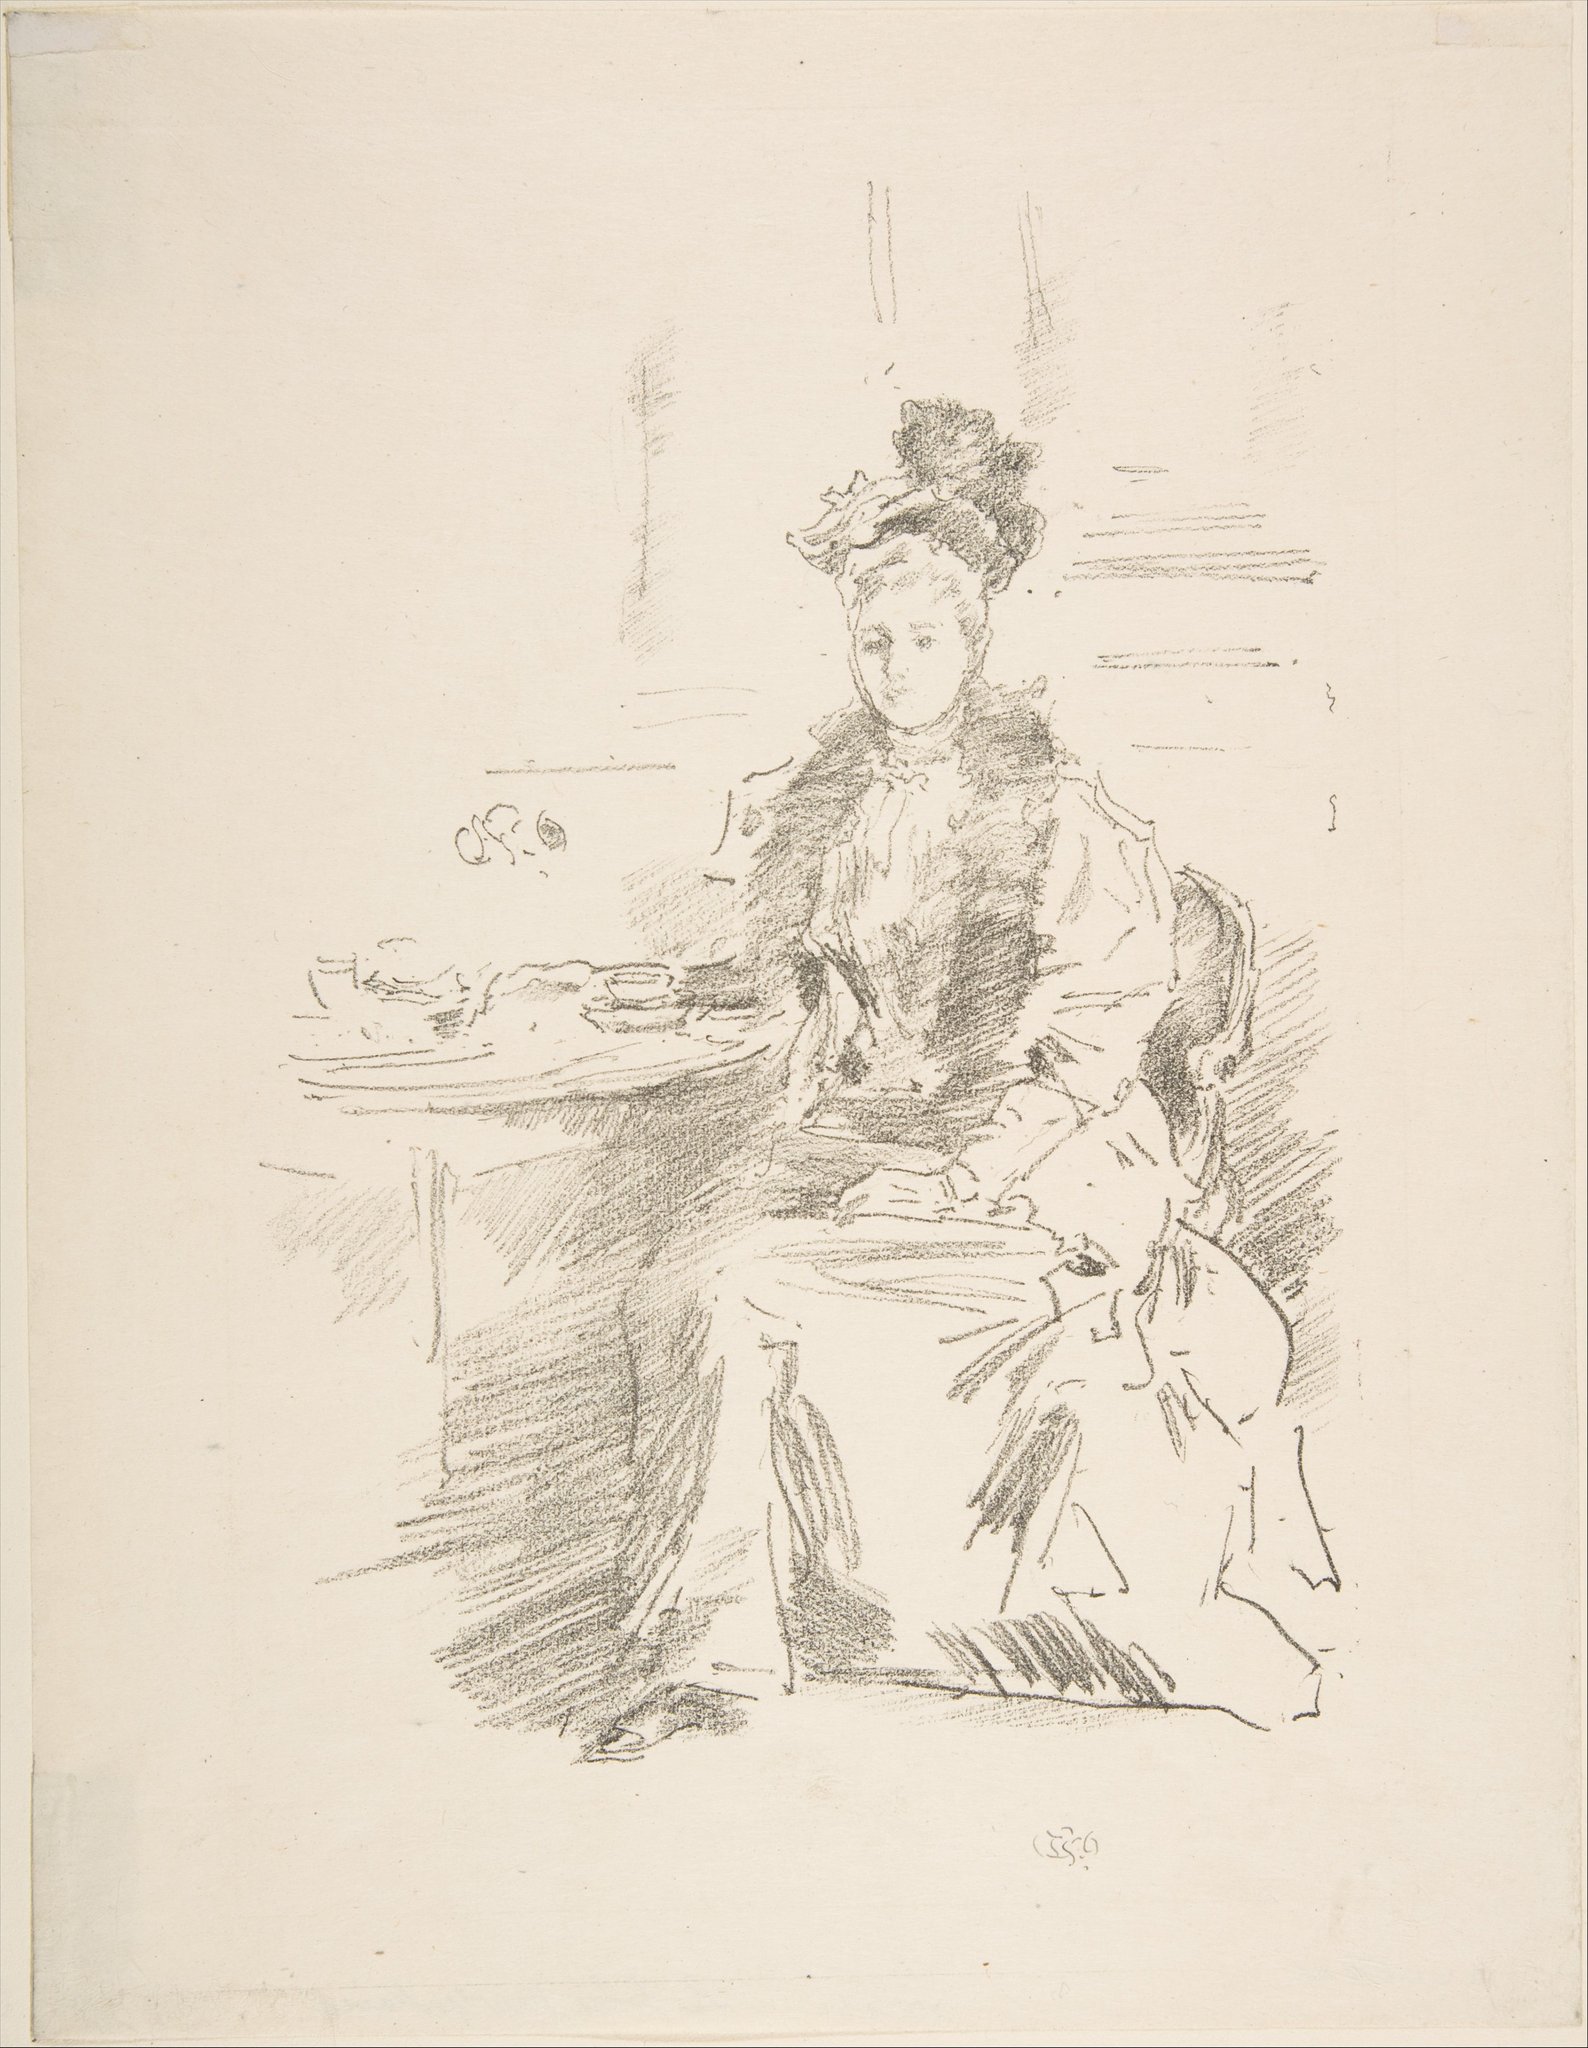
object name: print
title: La Jolie New Yorkaise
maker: james mcneill whistler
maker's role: artist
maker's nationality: american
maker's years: 1834-1903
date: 1894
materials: ink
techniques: printing, lithography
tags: women